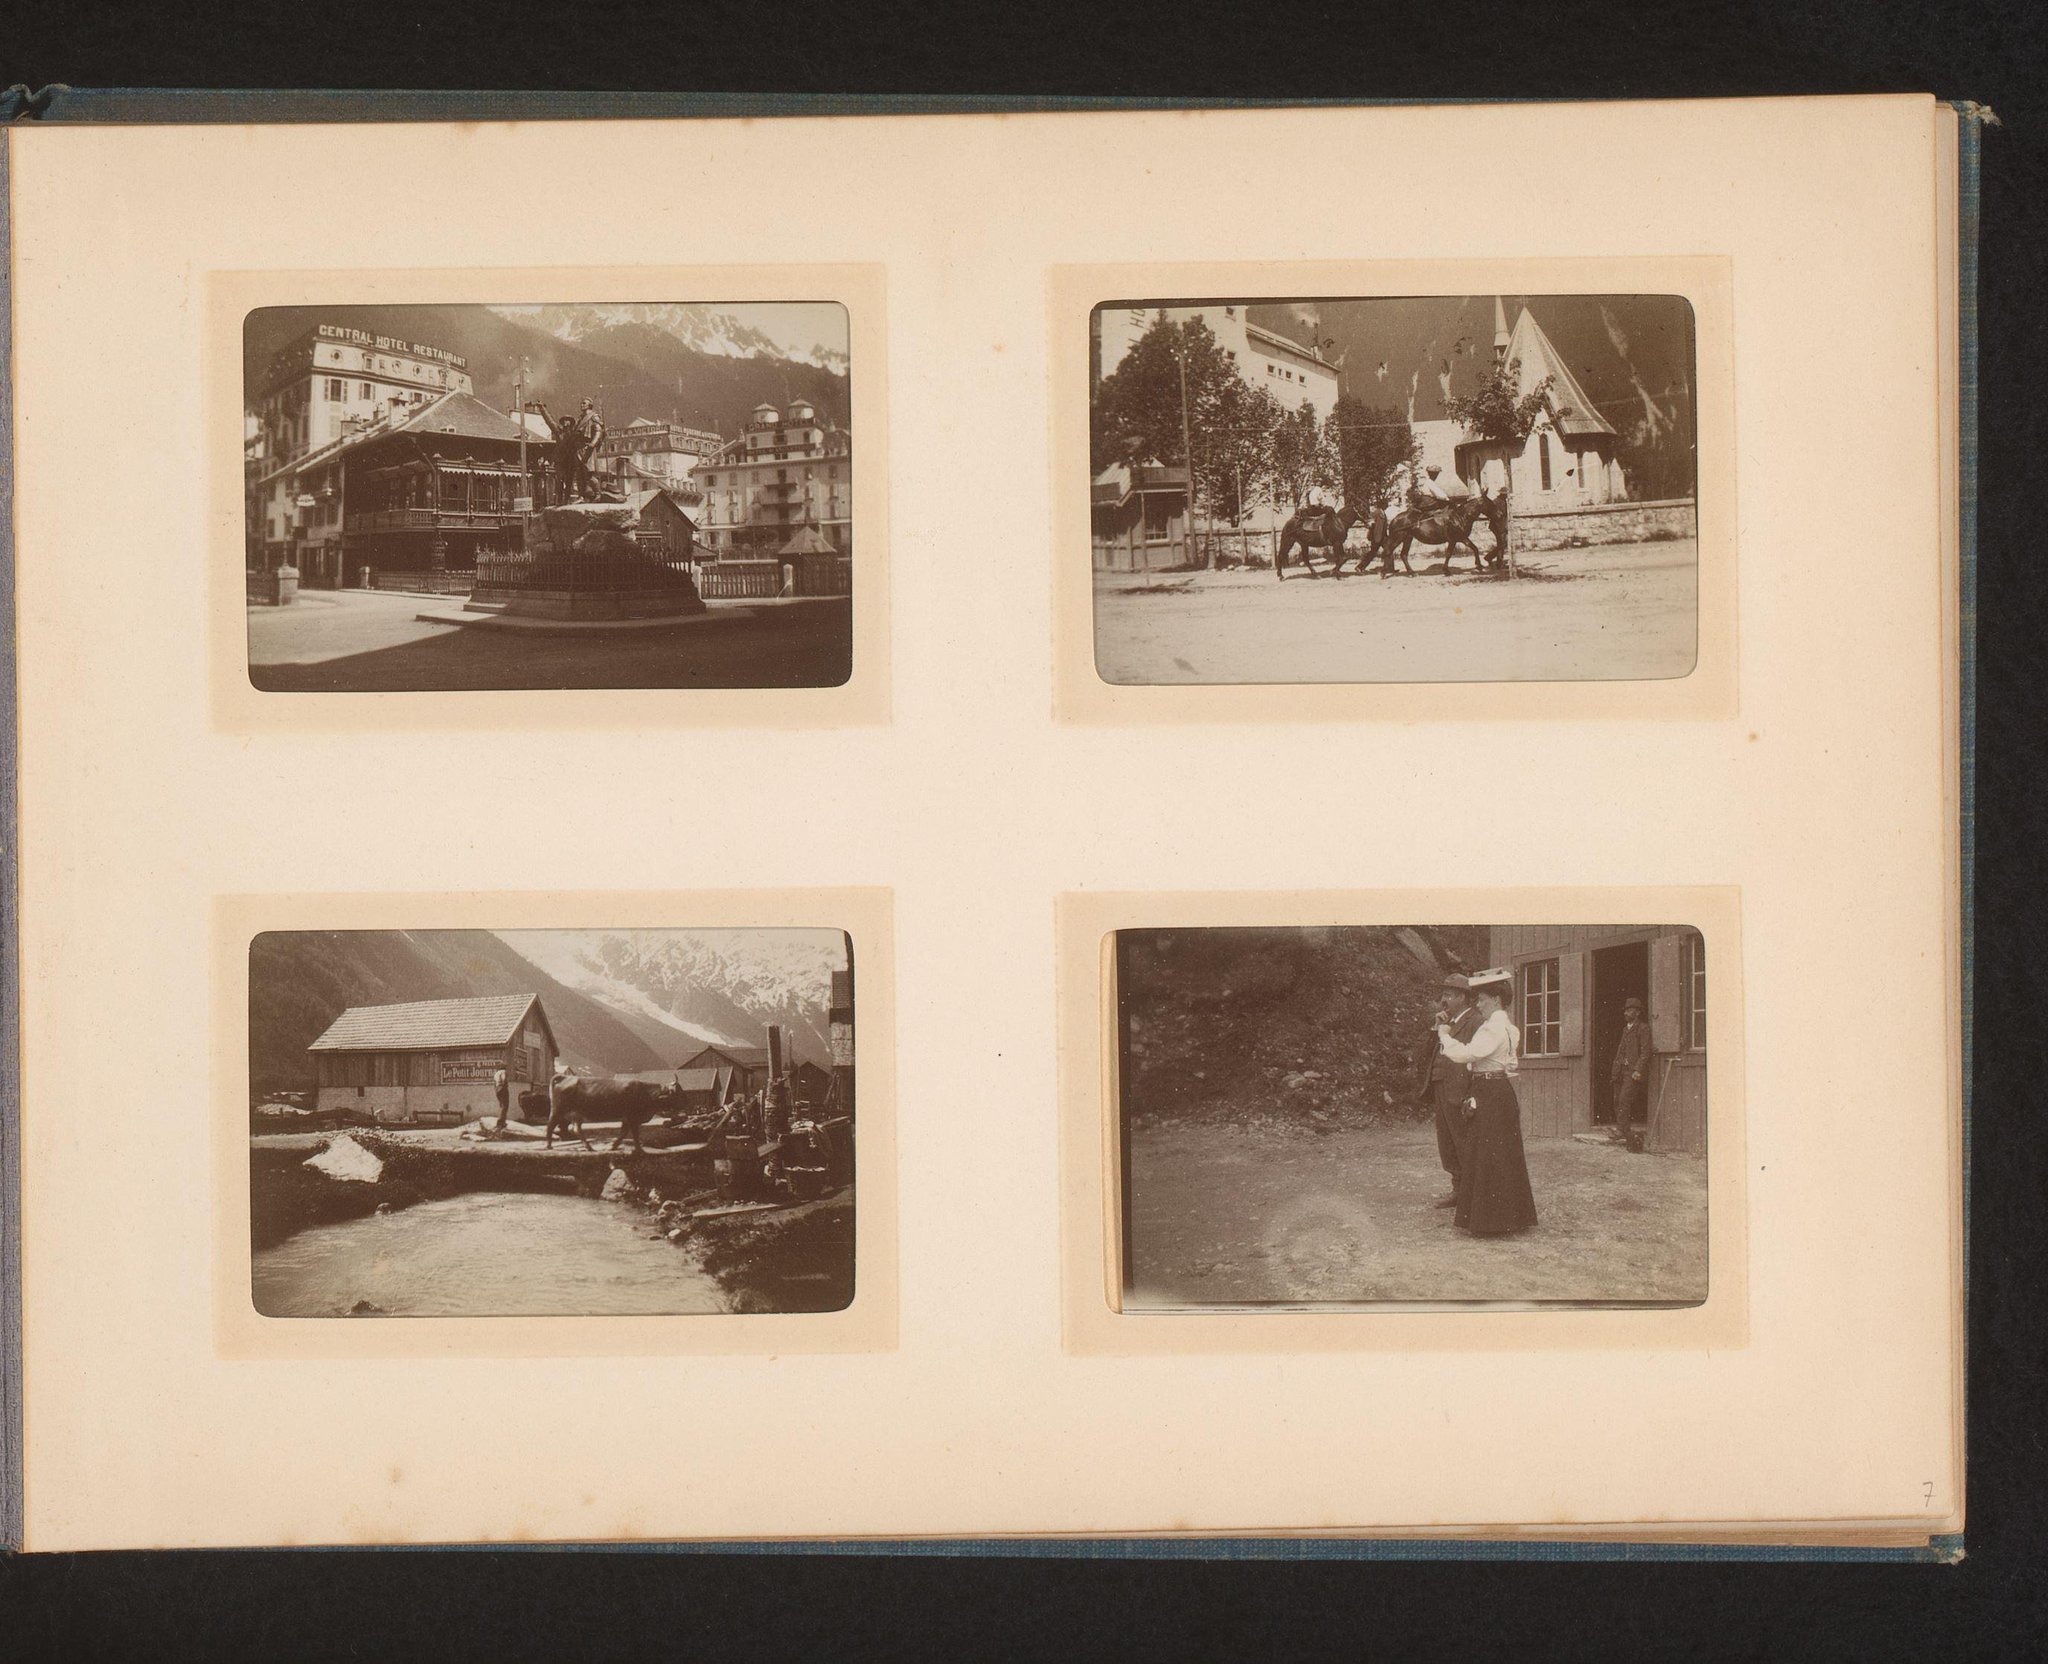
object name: photograph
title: Drie straatgezichten en Portret van een man en vrouw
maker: Anonymous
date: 1900-1915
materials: paper, photographic support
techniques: gelatin silver print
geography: france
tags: historical persons, travelling; tourism, civic architecture; edifices; dwellings, mountains, france